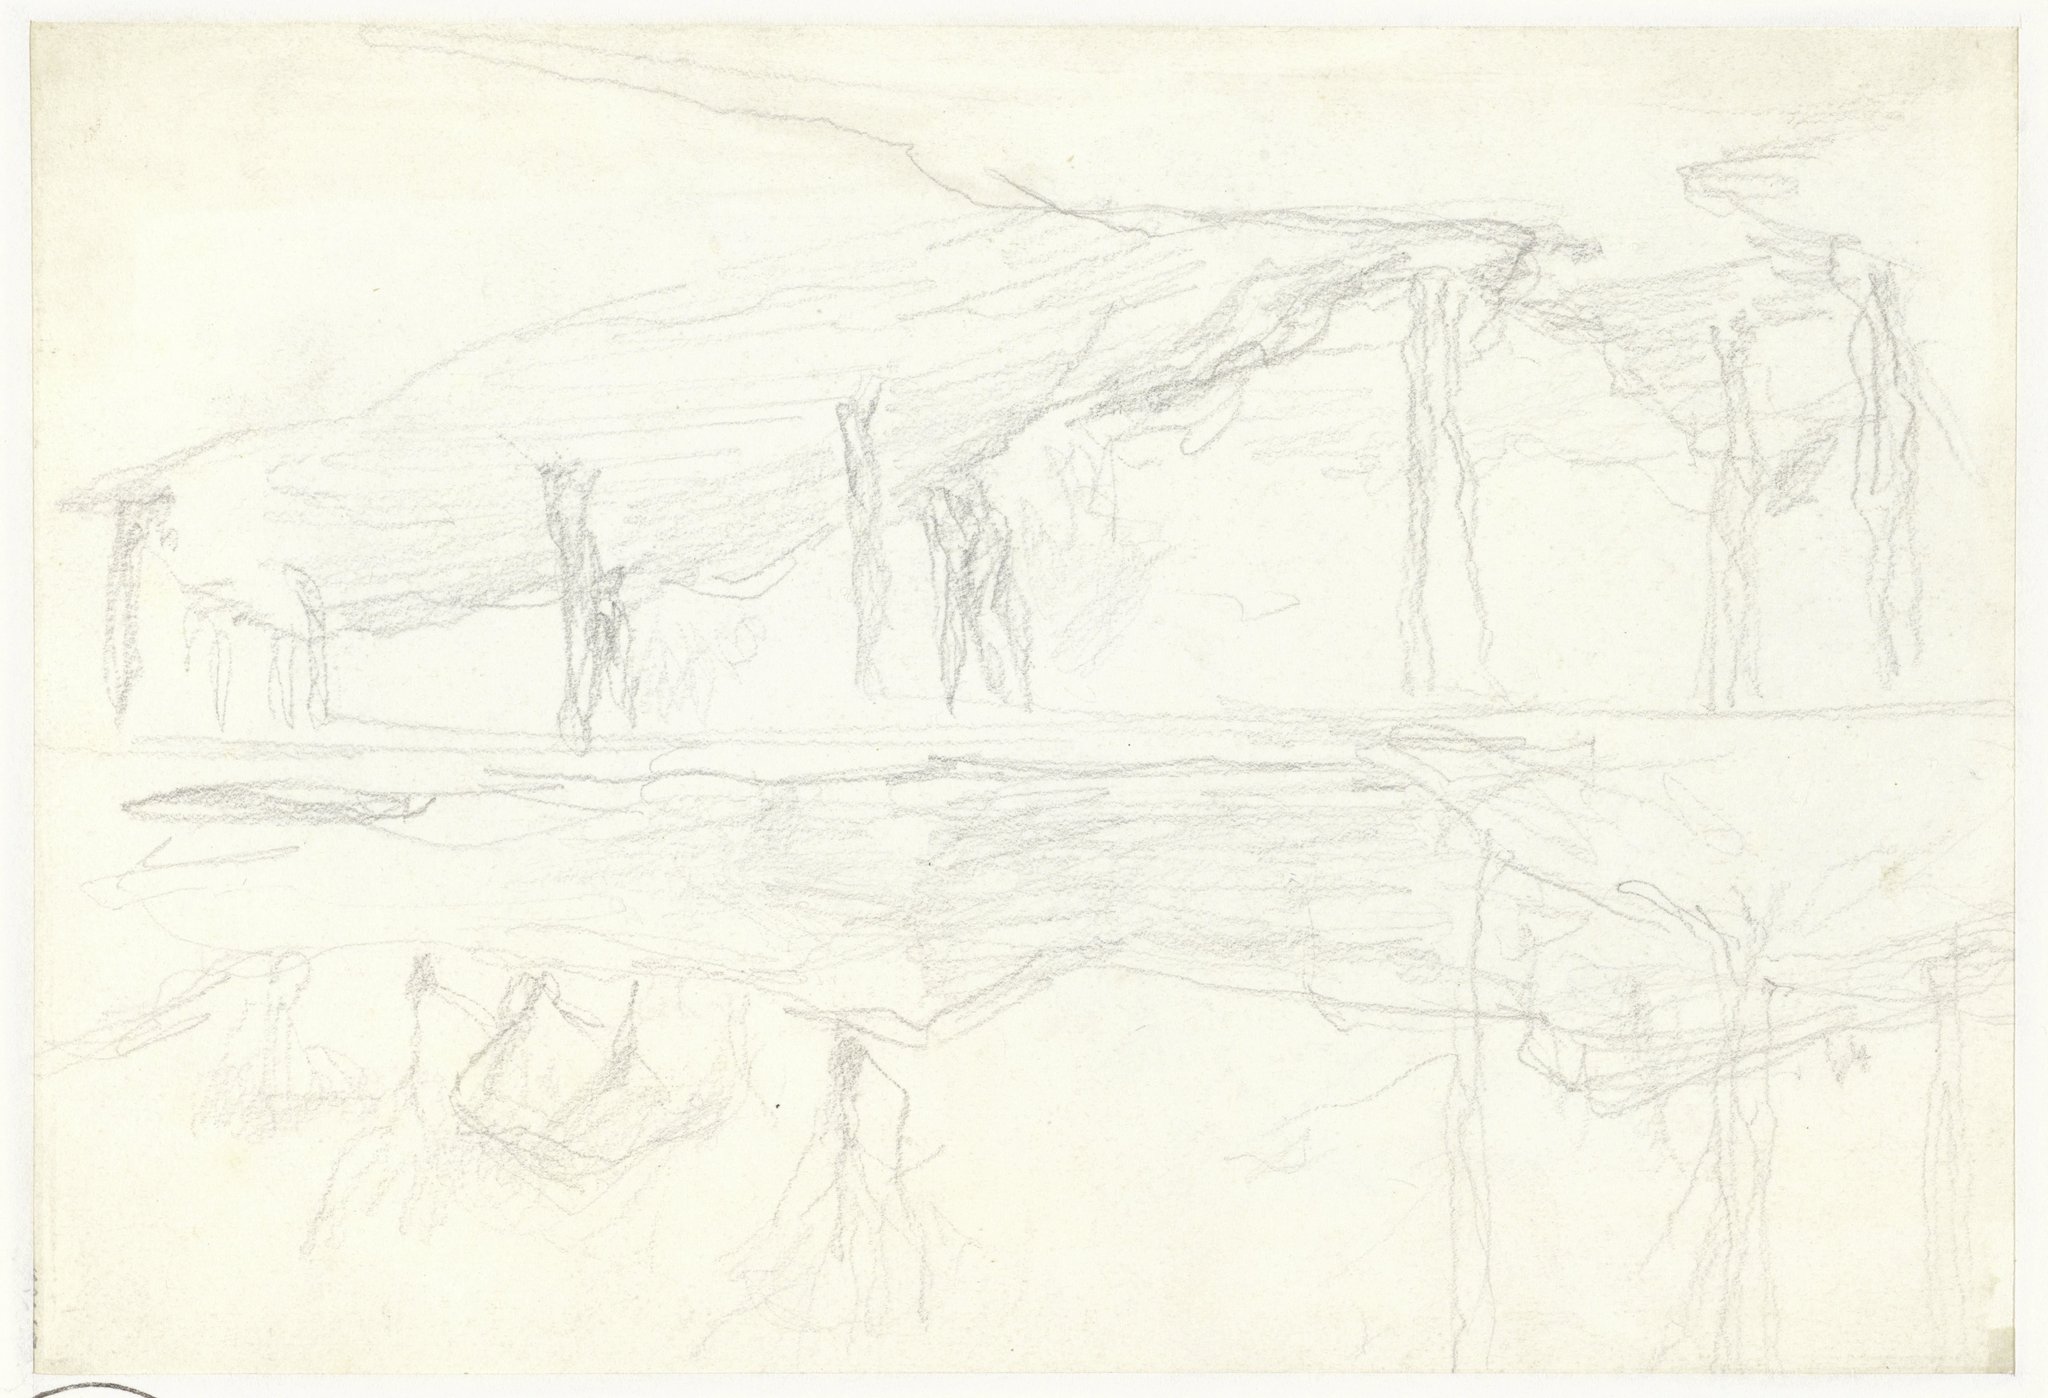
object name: drawing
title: Twee schetsen van een landschap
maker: matthijs maris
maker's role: draughtsman, painter, print maker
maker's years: 1839-1917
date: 1849-1917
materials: chalk, paper